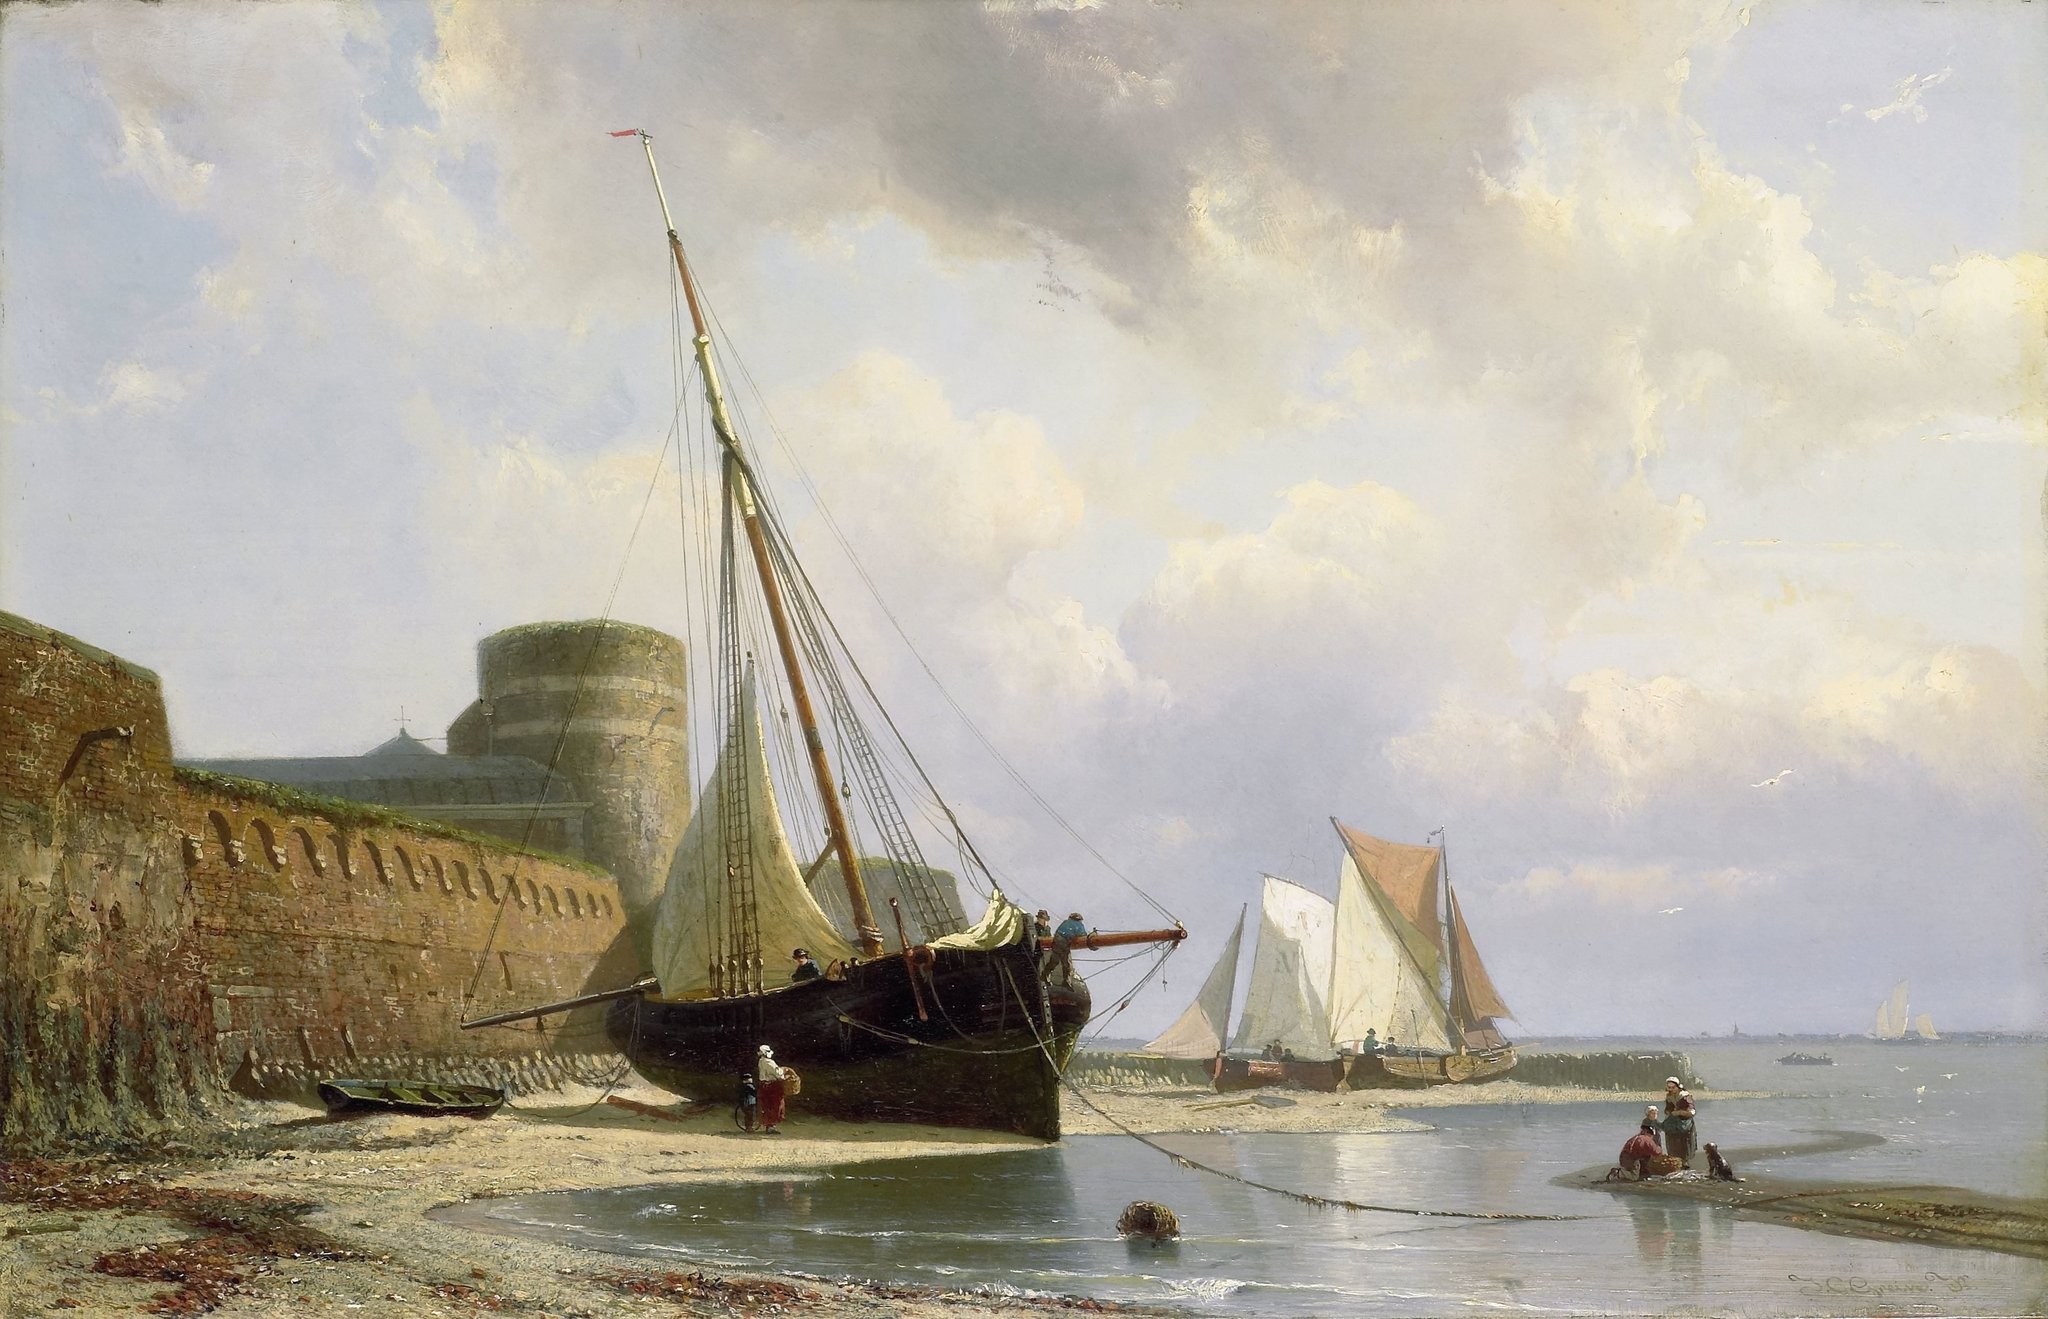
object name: painting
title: De bomvrije kazerne te Vlissingen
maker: johan conrad greive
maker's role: draughtsman, painter, print maker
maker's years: 1837-1891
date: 1850-1870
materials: oil, panel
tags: fortress, sailing-ship, sailing-boat, barracks, flushing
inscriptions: signature: ‘J.C. Greive Jr.’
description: De bomvrije kazerne te Vlissingen, ca. 1860.